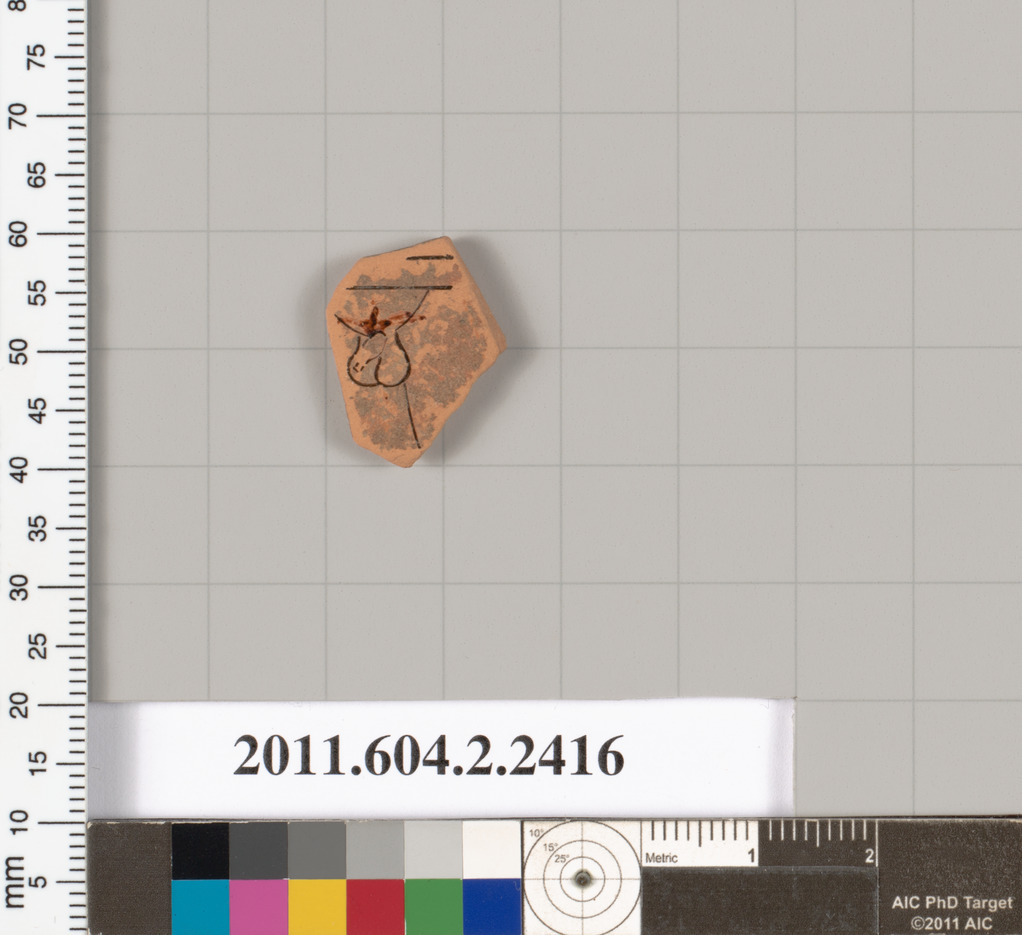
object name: undetermined shape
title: Terracotta fragment of an undetermined shape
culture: greek, attic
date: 490-470 BCE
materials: terracotta